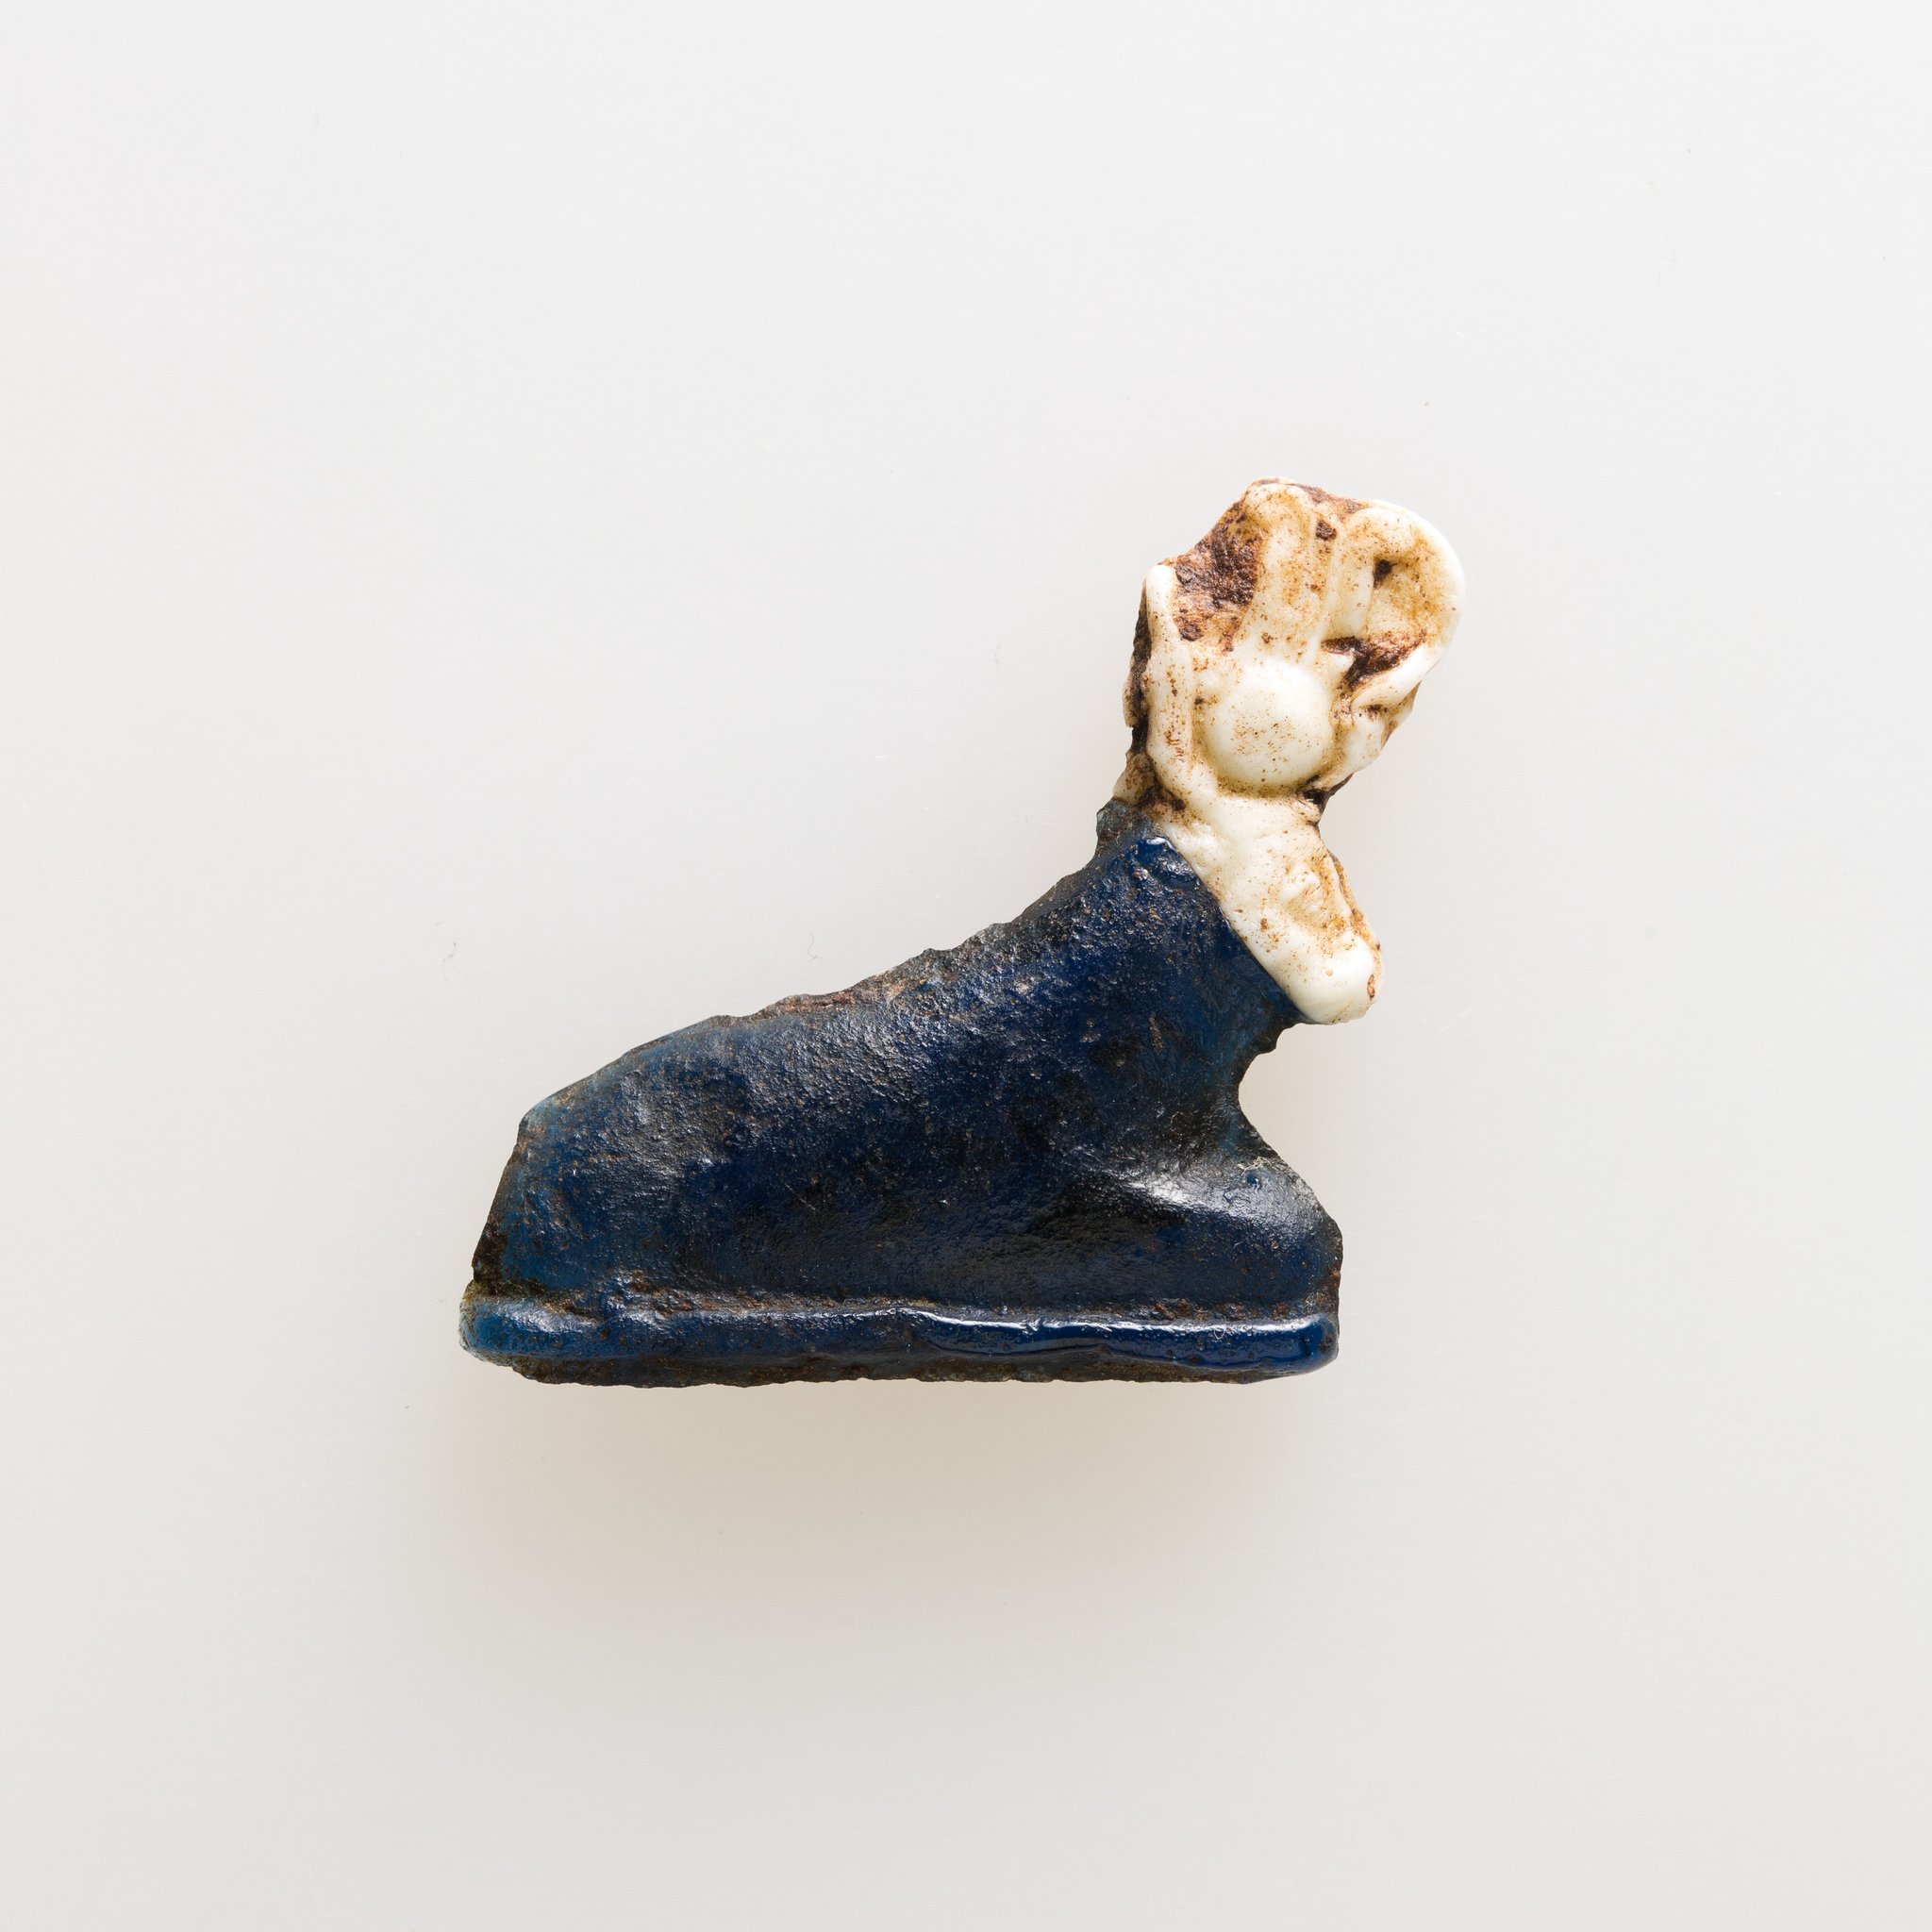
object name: amulet, cow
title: Amulet of kneeling cow wearing disk and feathers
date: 400-30 BCE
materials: glass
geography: egypt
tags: cows